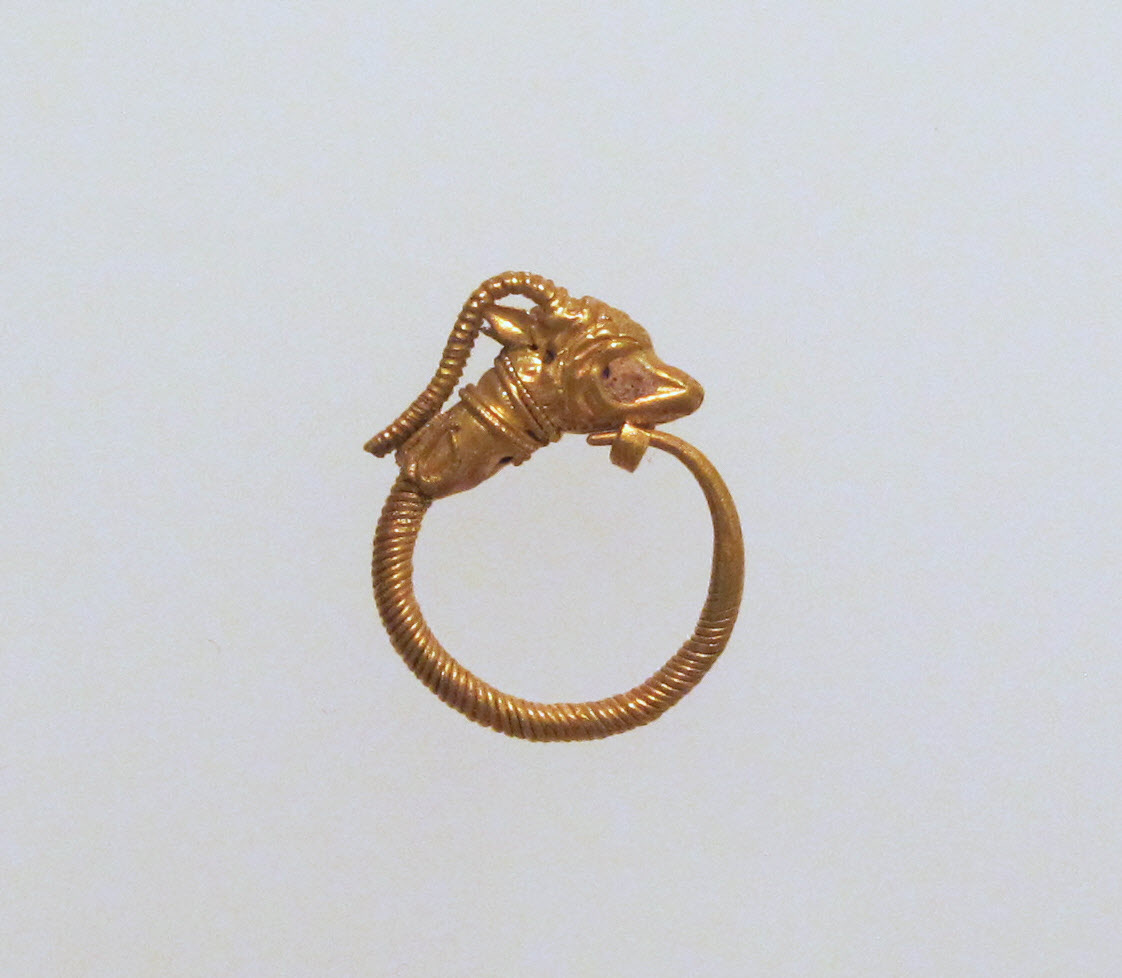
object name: earring with head of antelope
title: Gold earring with head of an antelope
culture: greek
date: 400-201 BCE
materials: gold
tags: animals